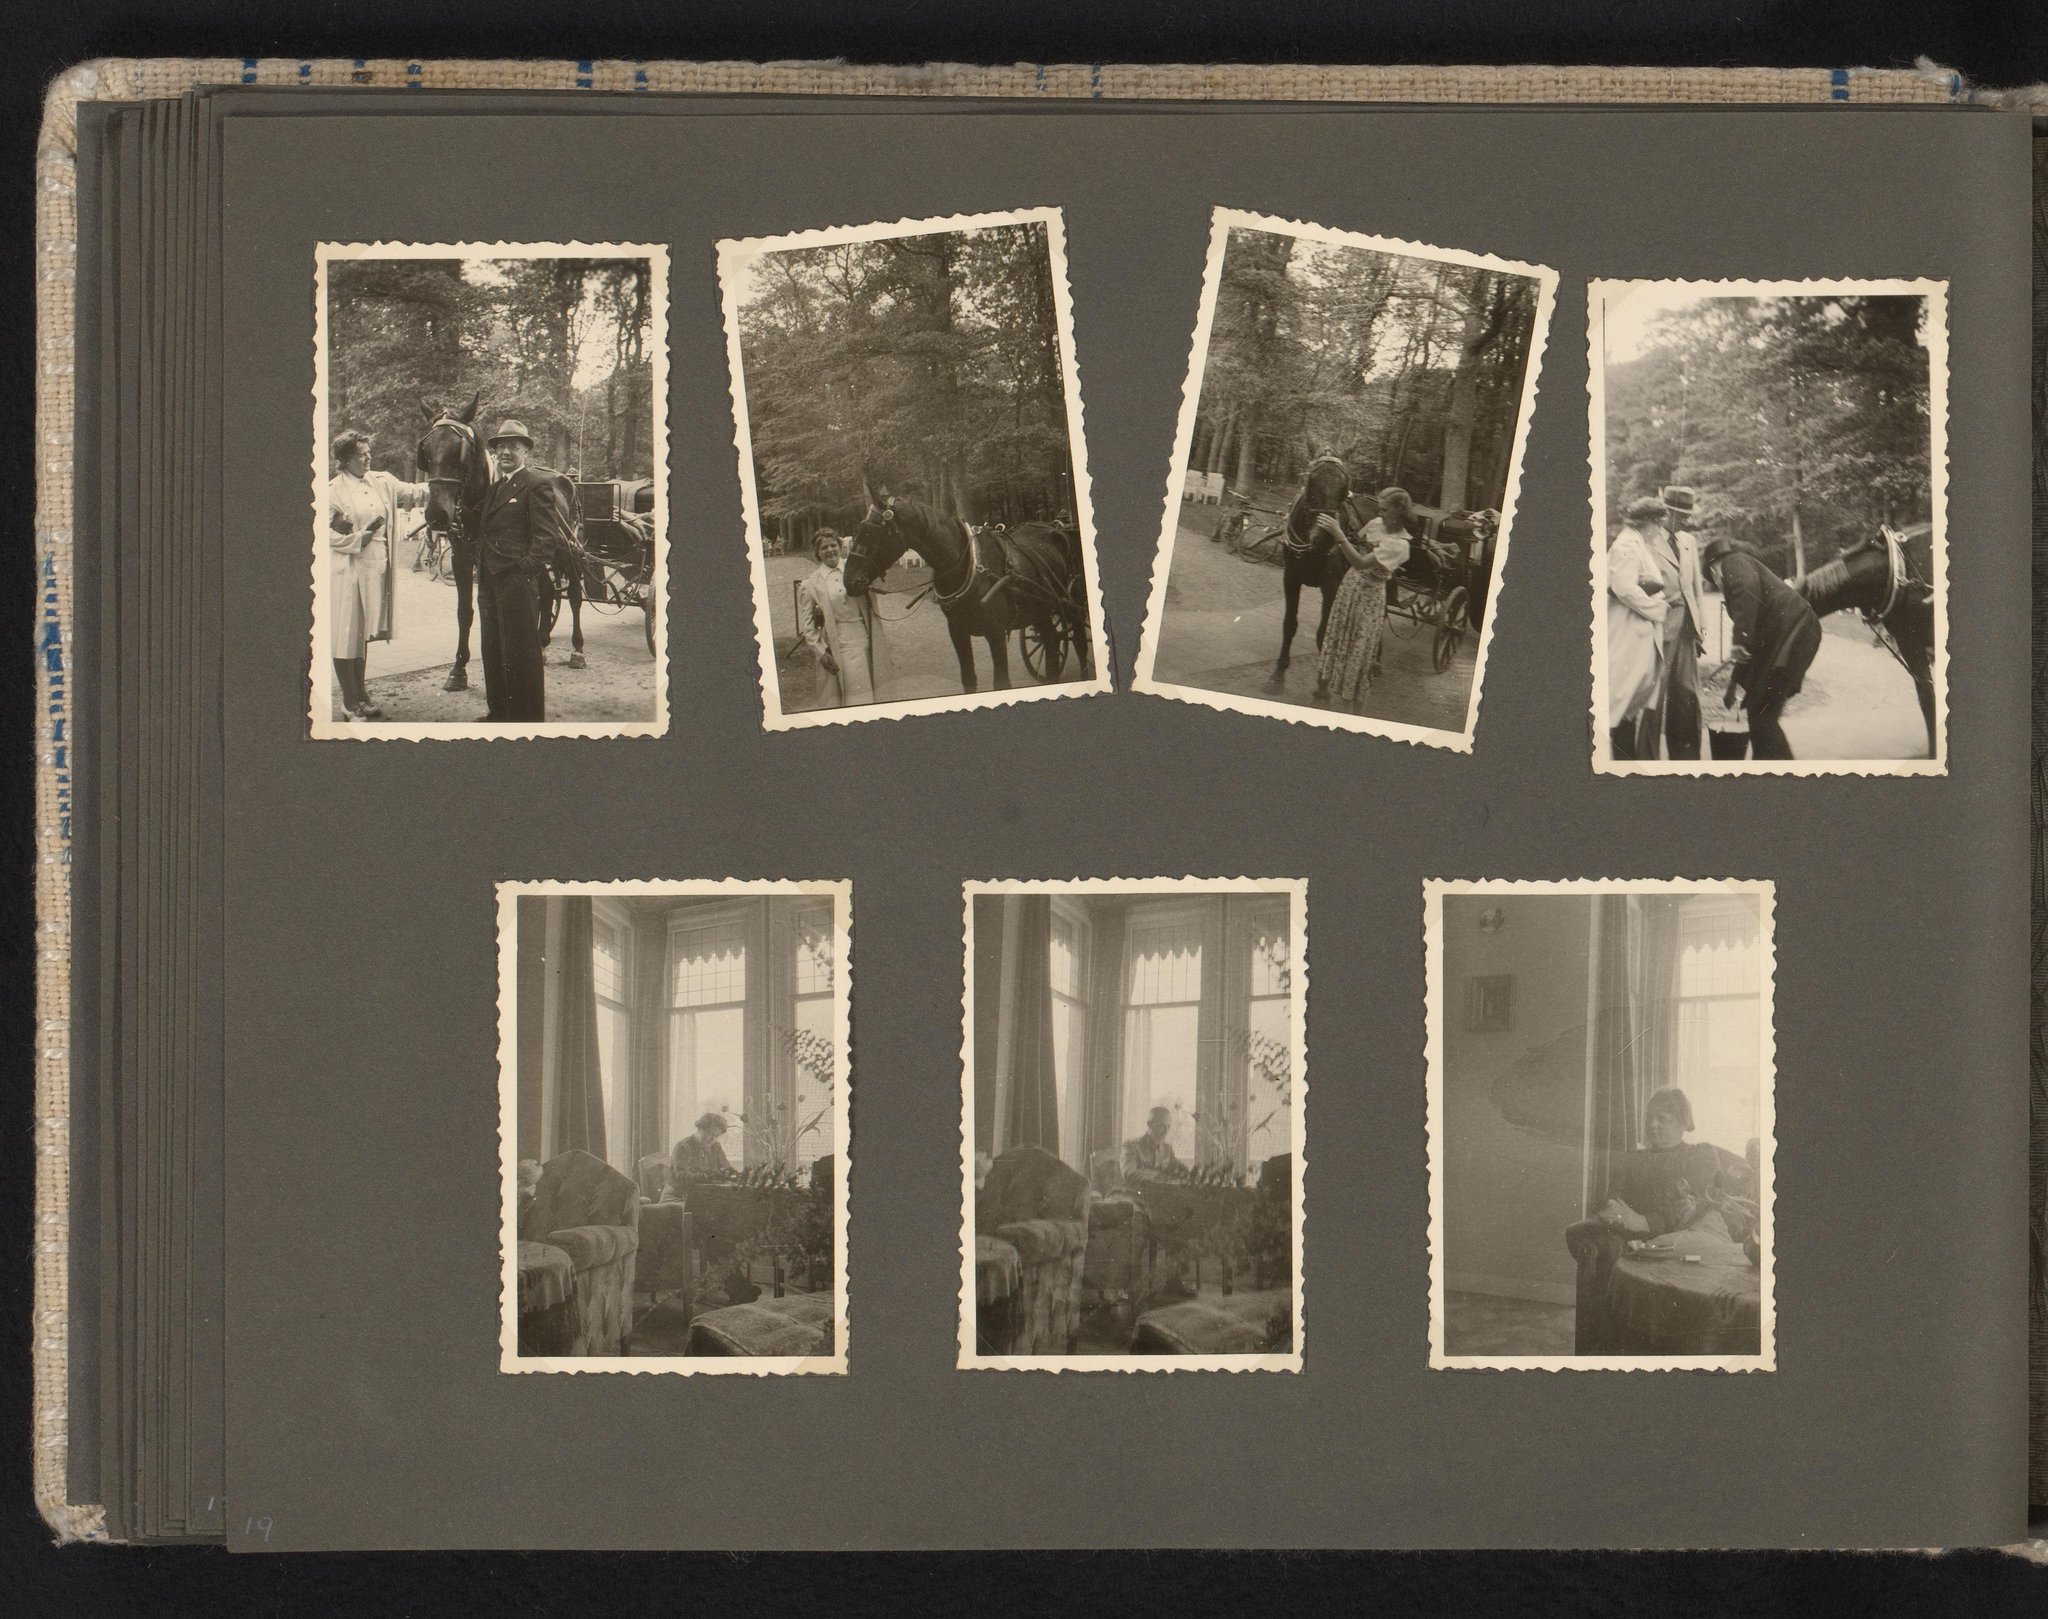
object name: album leaf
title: Paard en wagen en huiskamer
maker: Anonymous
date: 1941-1942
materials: cardboard, photographic support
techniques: gelatin silver print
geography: netherlands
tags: interior of the house, the soldier off duty, occupation ~ war, wood and park (as places of recreation), netherlands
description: Albumblad met zeven foto's van een uitje met familie en vrienden bij een bos en interieur van huiskamer. Onderdeel van het fotoalbum Abrechnungsintendantur van de Wehrmacht 1941-1943.